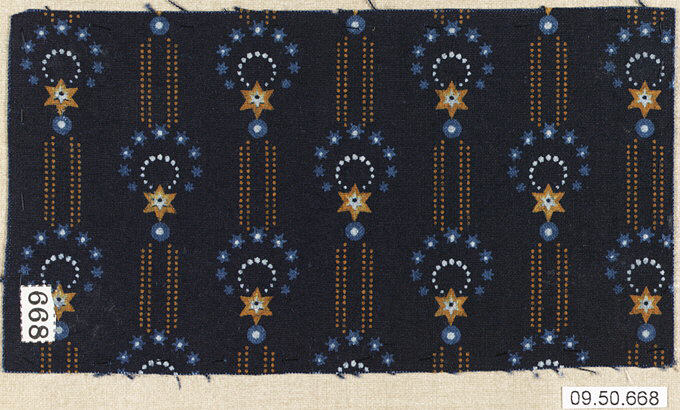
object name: piece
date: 1801-1900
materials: cotton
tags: stars